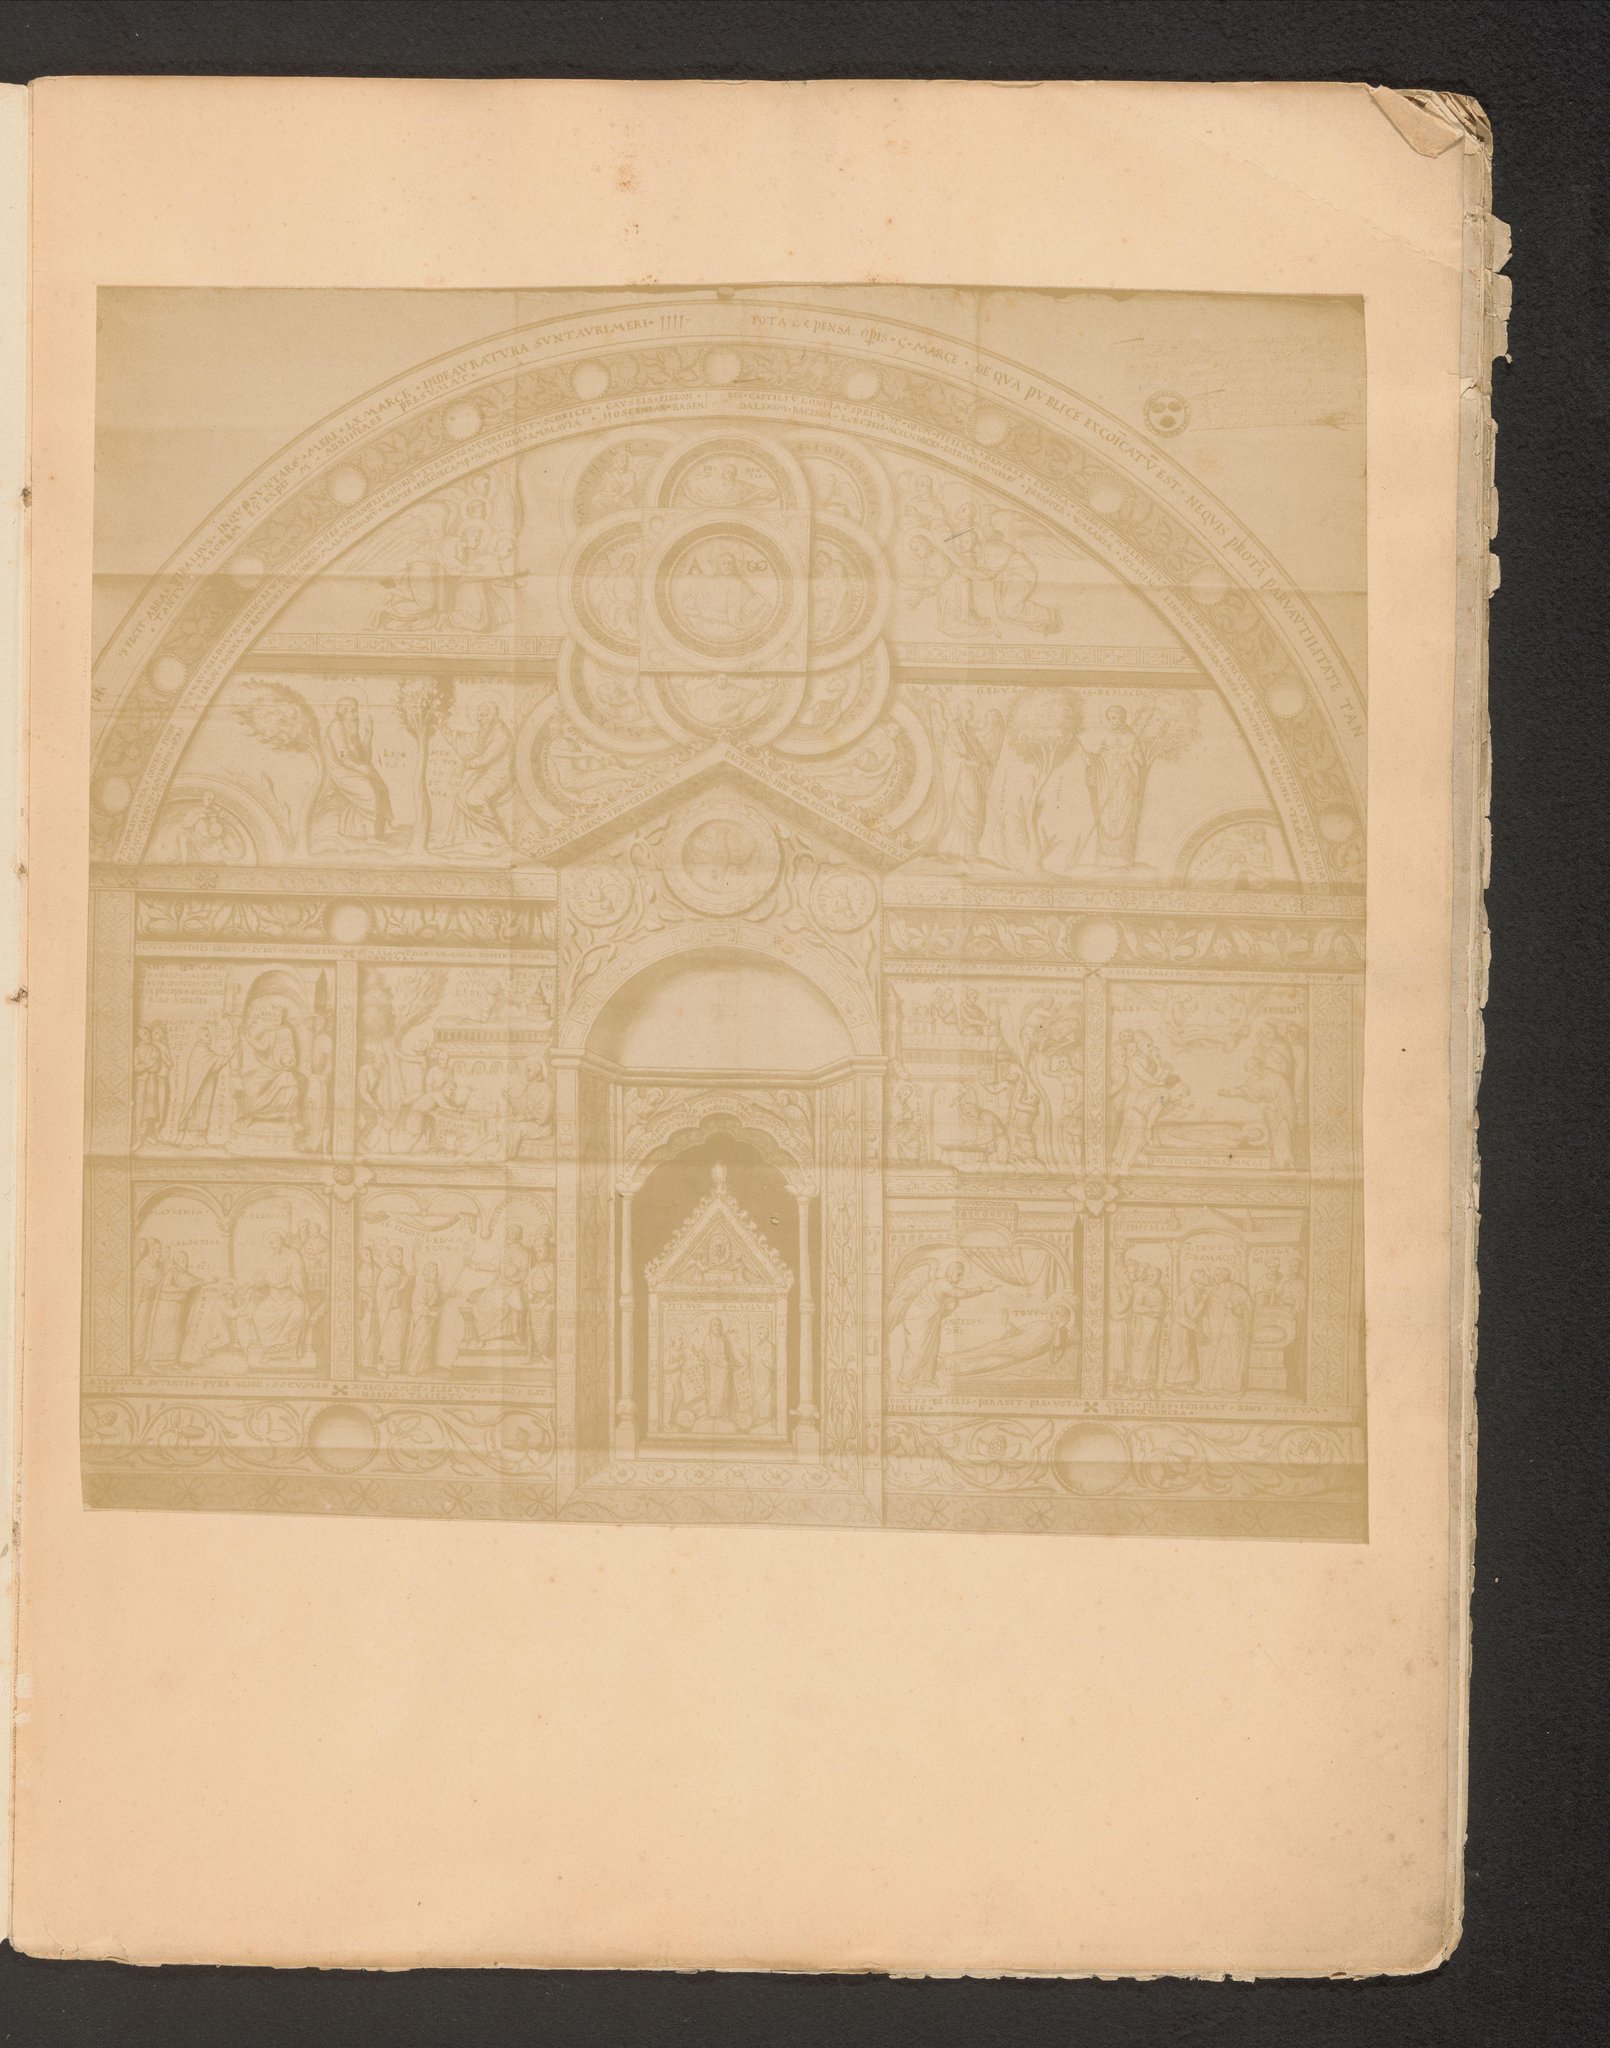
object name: page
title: Fotoreproductie van een ontwerp van een altaarstuk voor de abdij van Stavelot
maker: Anonymous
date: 1877-1882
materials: photographic support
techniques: albumen print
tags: altar accoutrement